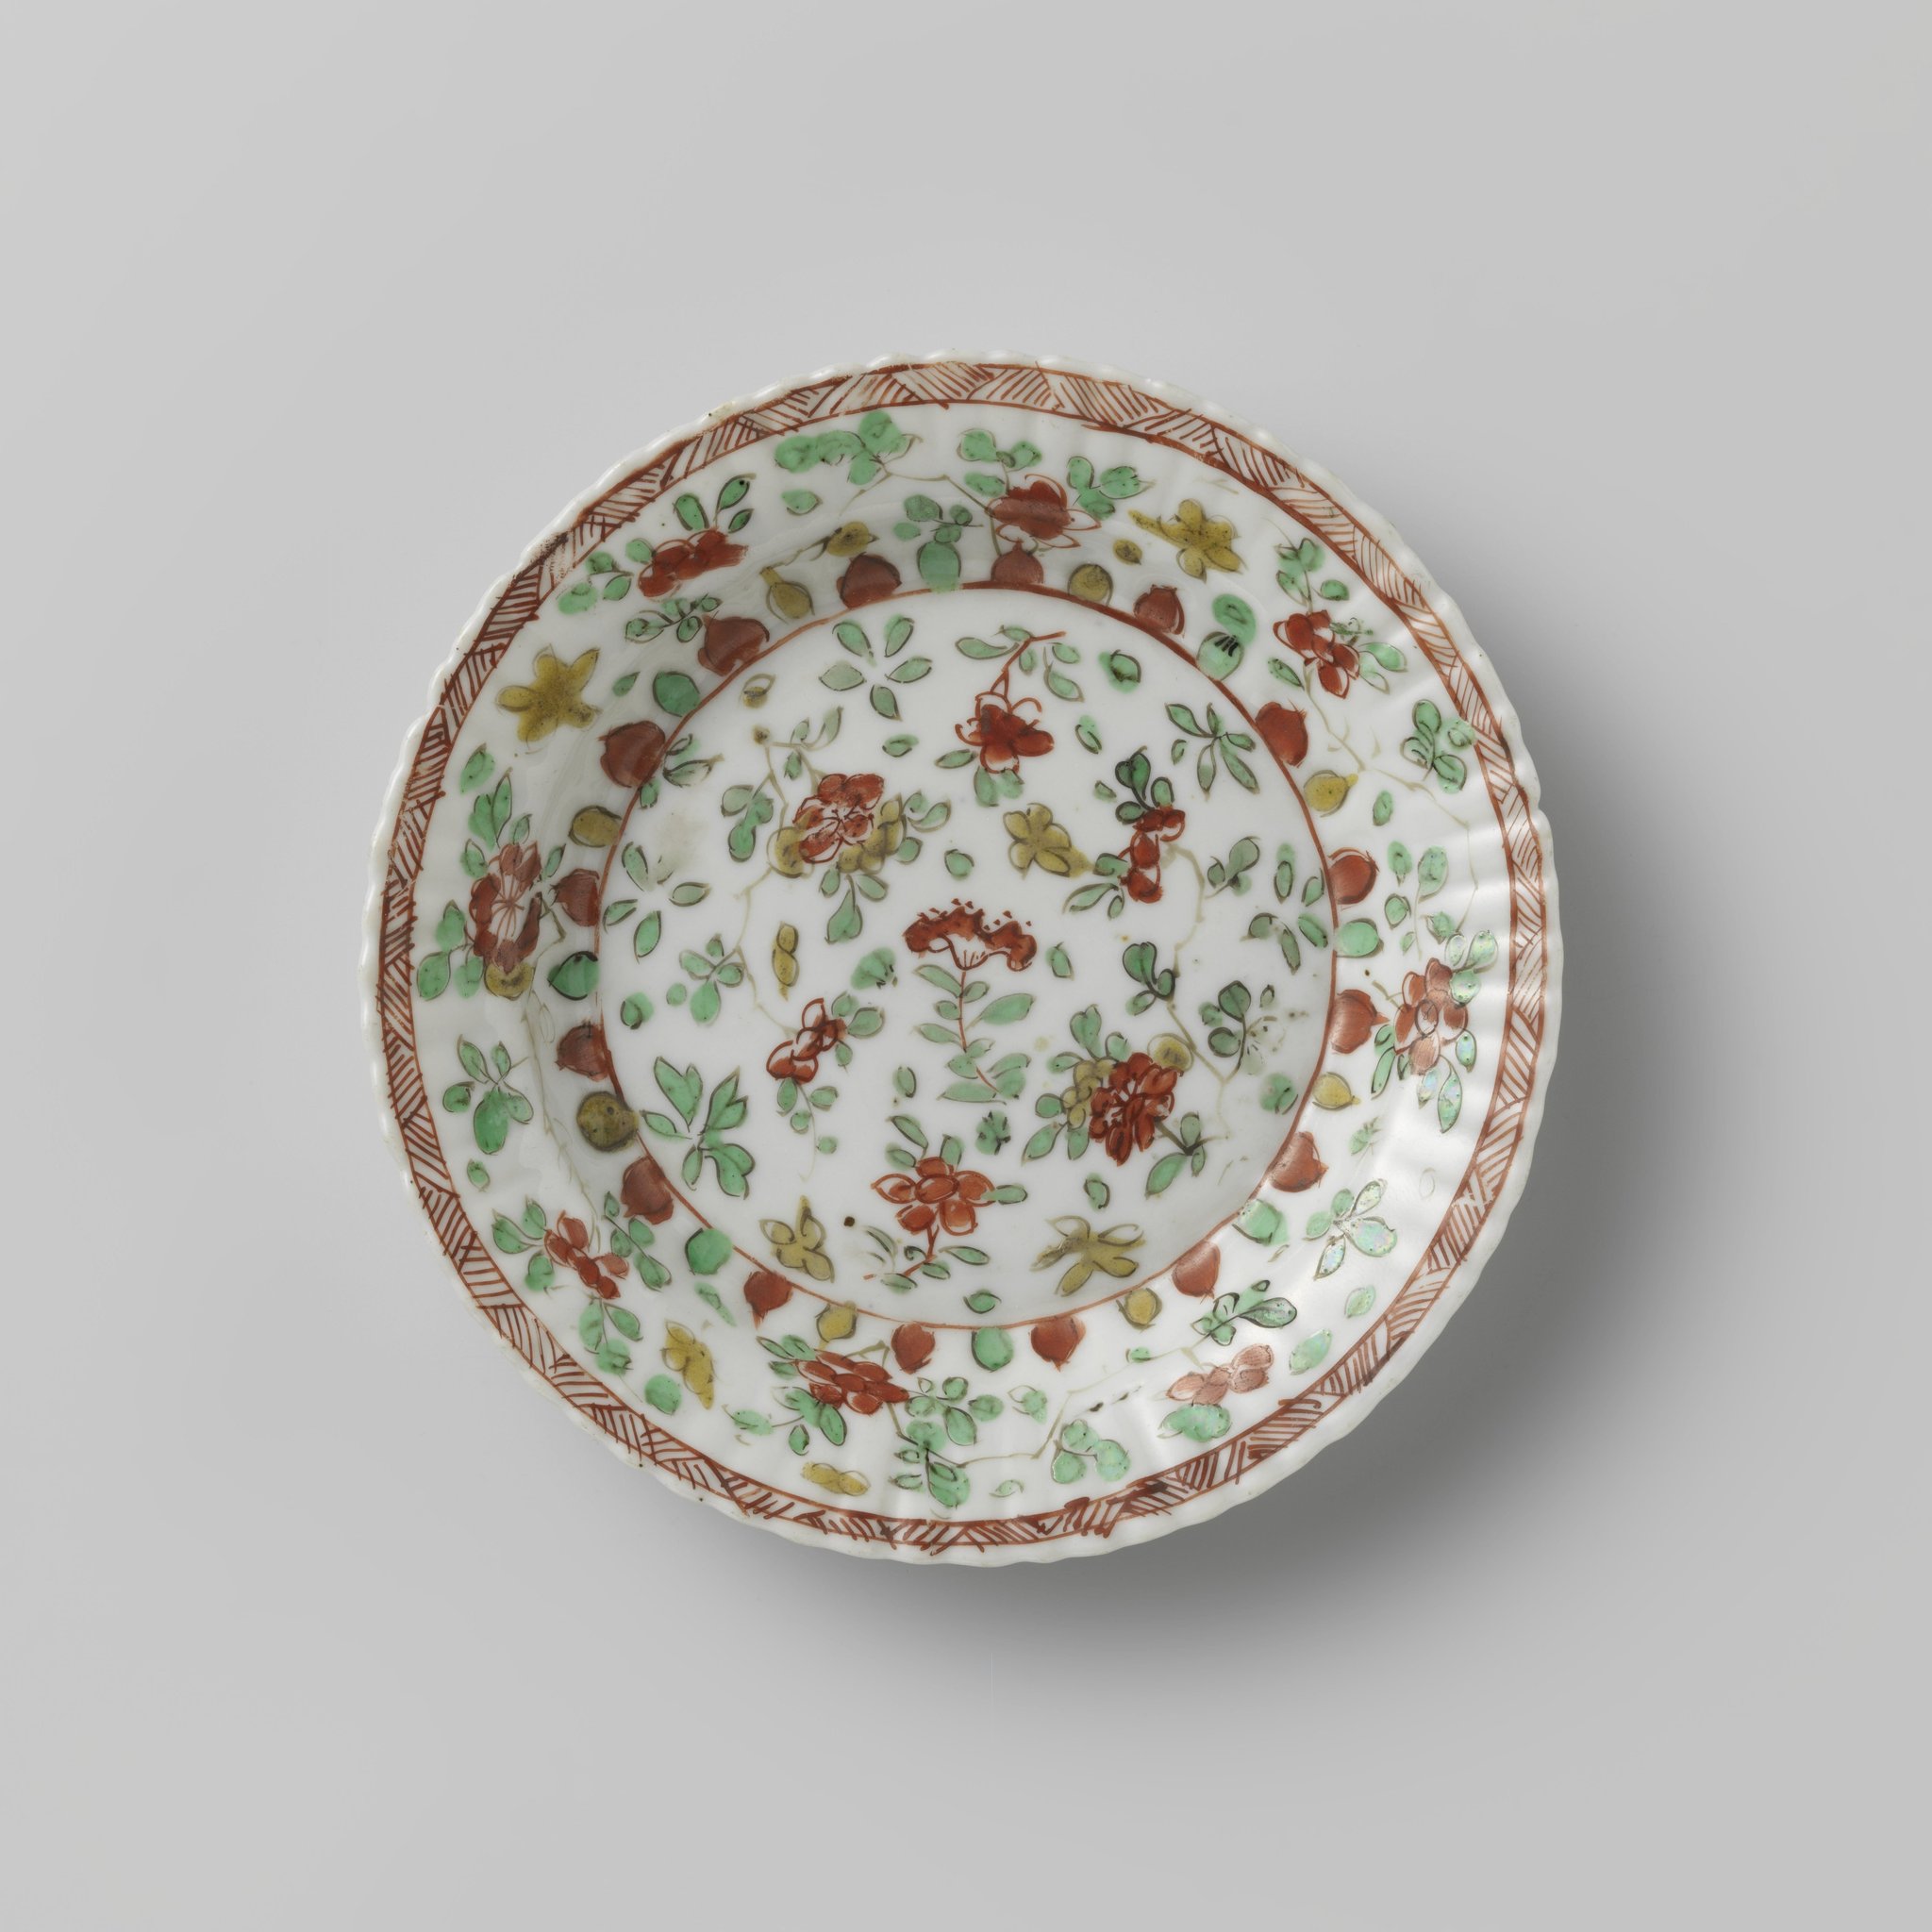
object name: platter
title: Saucer with scattered flower sprays and border of standing petals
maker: Anonymous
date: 1700-1724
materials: cobalt, glaze, paint, porcelain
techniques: firing, turning, vitrification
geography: china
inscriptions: mark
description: Schotel, polychroom (famille verte) versierd met strooibloemen.